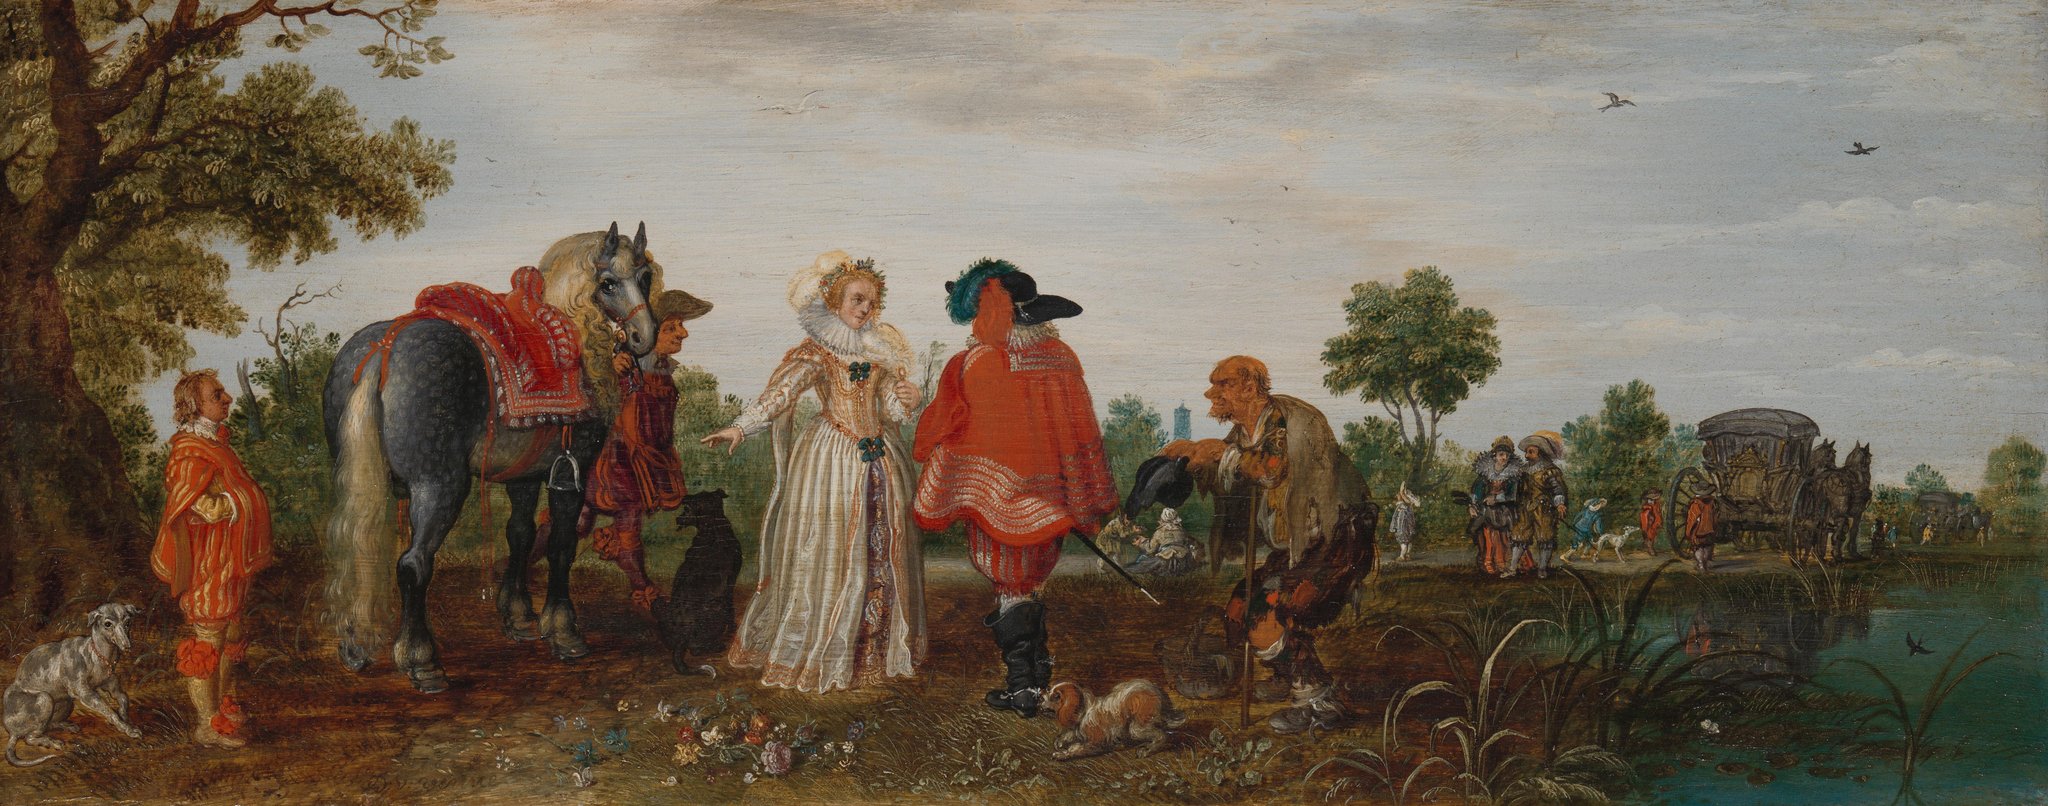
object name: painting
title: Spring (The Meeting)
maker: adriaen pietersz van de venne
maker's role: draughtsman, painter, print maker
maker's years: 1589-1662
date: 1625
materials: oil, panel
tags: beggar, meeting, spring landscape; landscape symbolizing spring (the four seasons of the year), dog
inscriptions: signature and date, bottom left (A and D ligated): ‘1625 / AD: v: Venne’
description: Lente. Op een weg langs een rivier is een ruiter van zijn paard gestegen om een praatje te maken met een elegante vrouw, rechts een bedelaar. Tussen de figuren zitten drie honden, in de verte wandelaars en een rijtuig. Onderdeel van een reeks met de vier jaargetijden, SK-A-1771/1774.